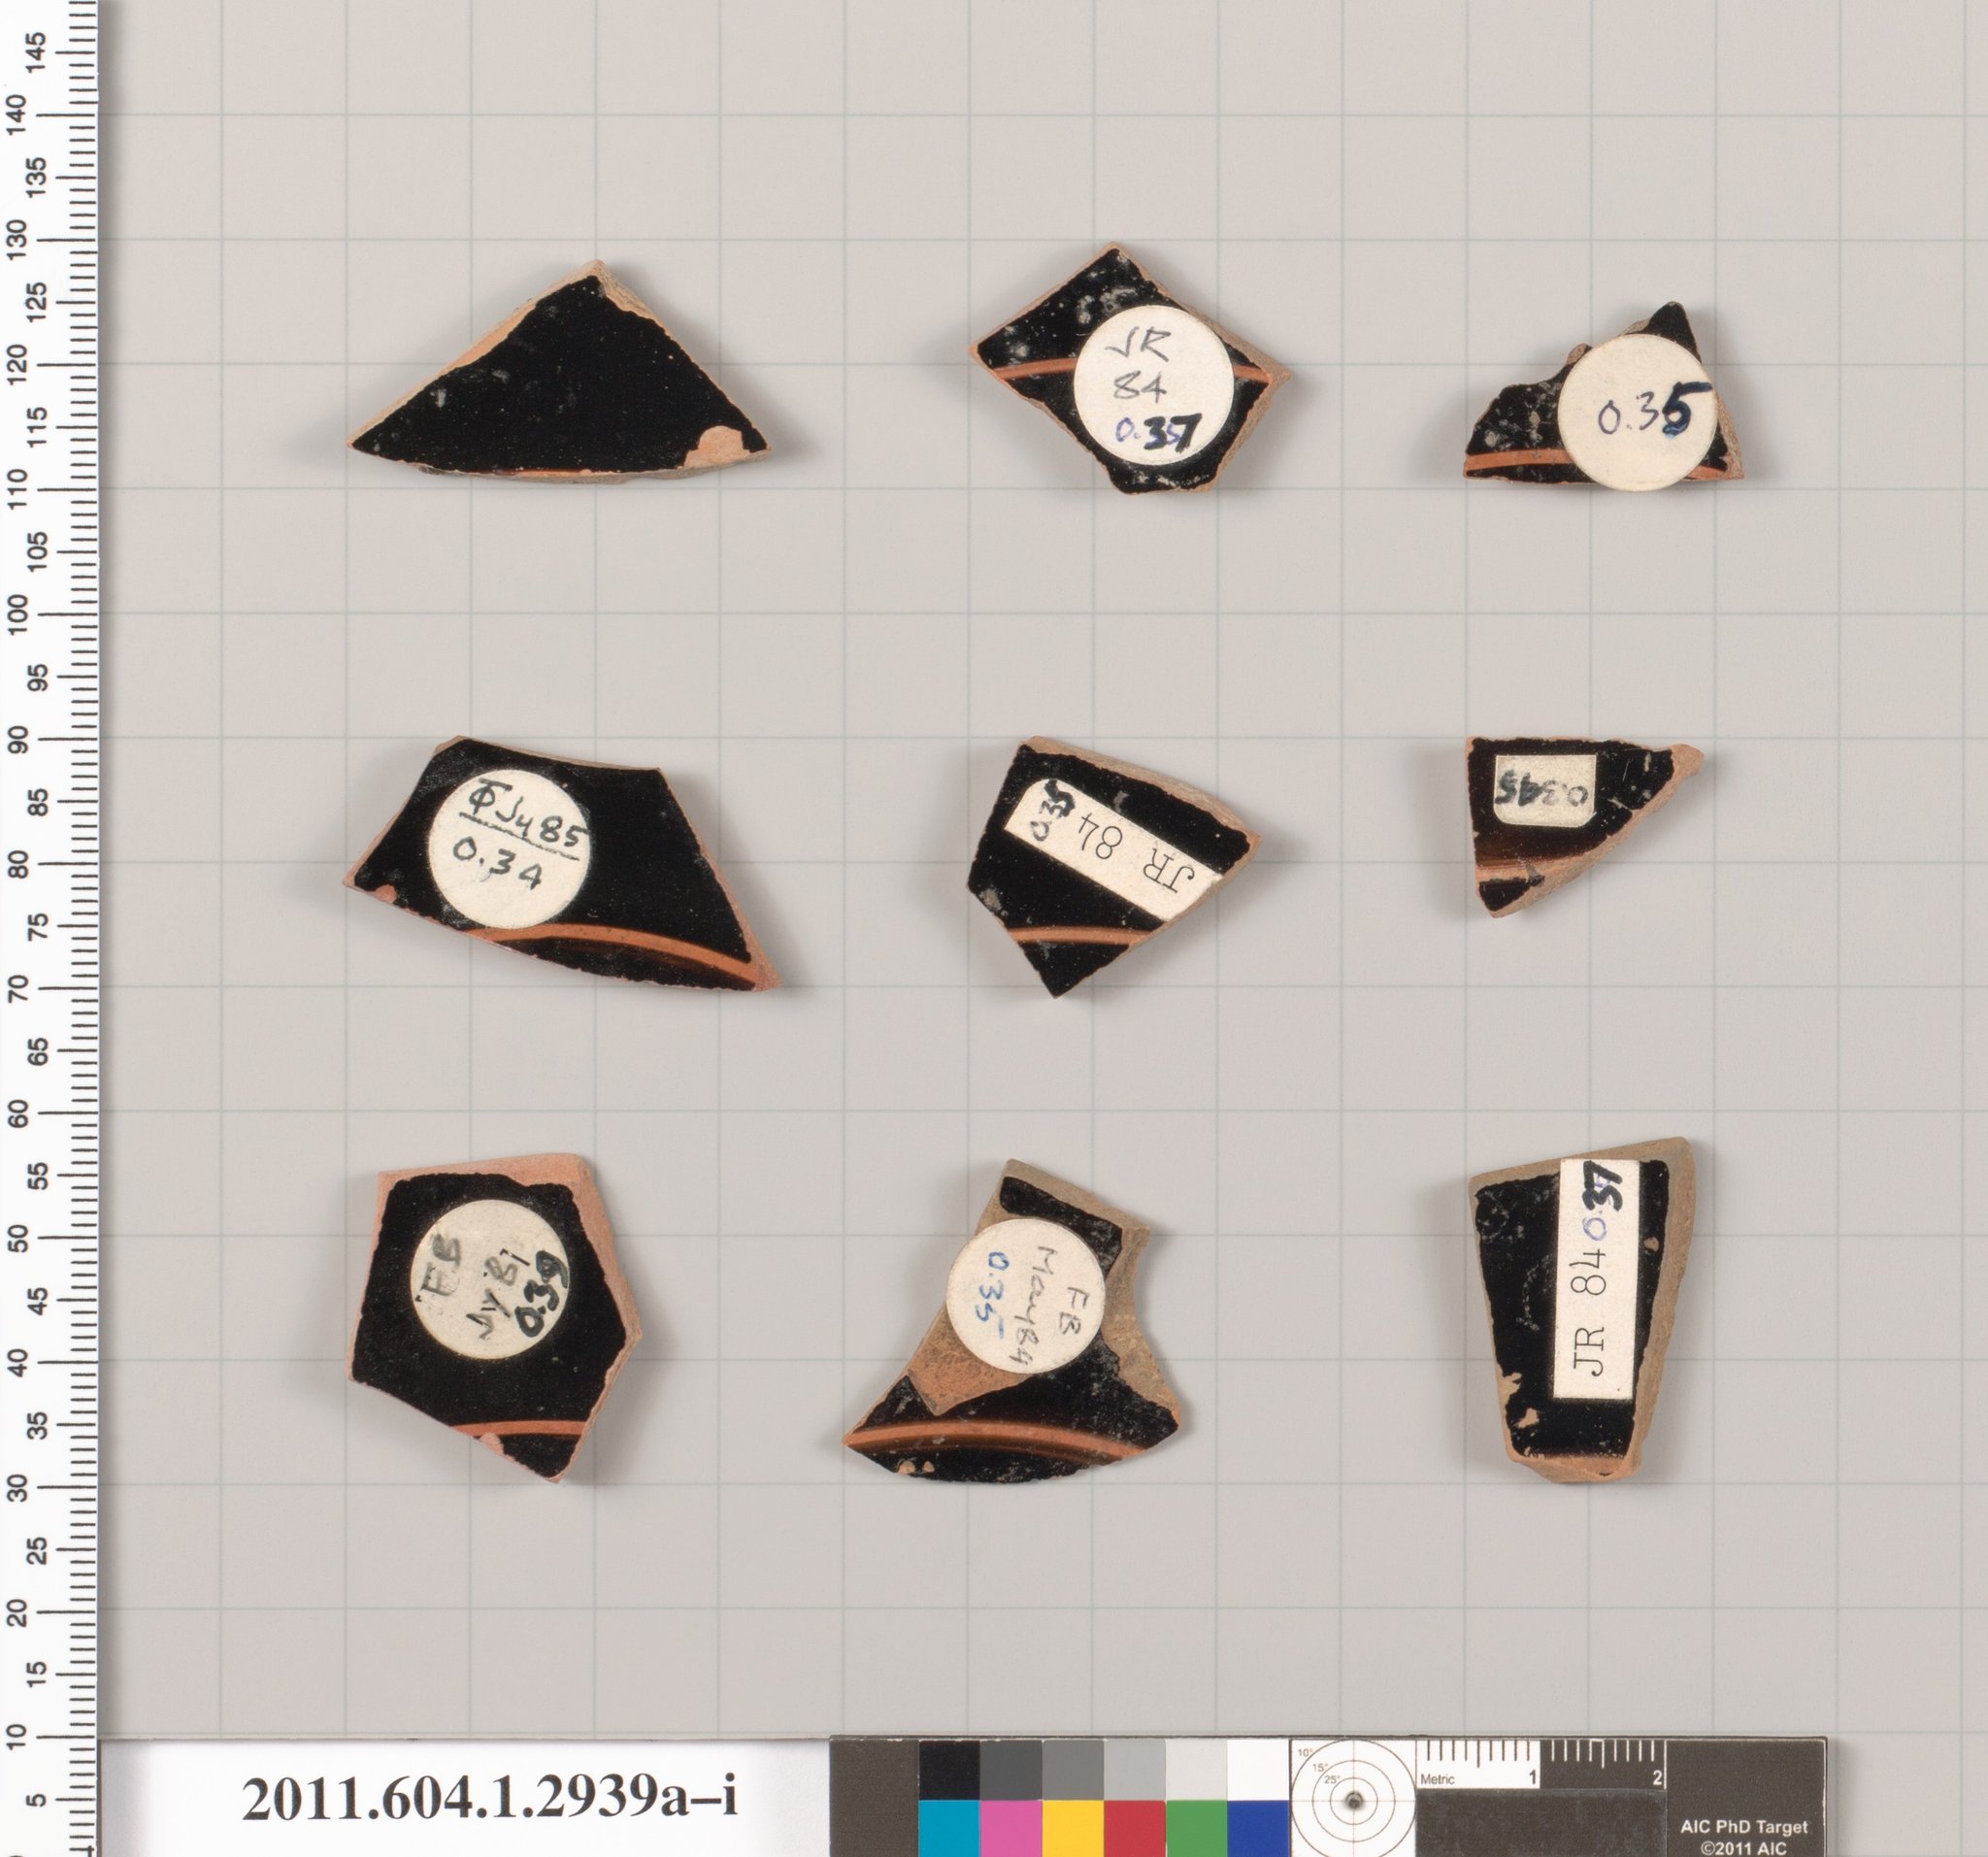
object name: kylix fragment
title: Terracotta fragments of kylikes (drinking cups)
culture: greek, attic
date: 500-476 BCE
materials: terracotta